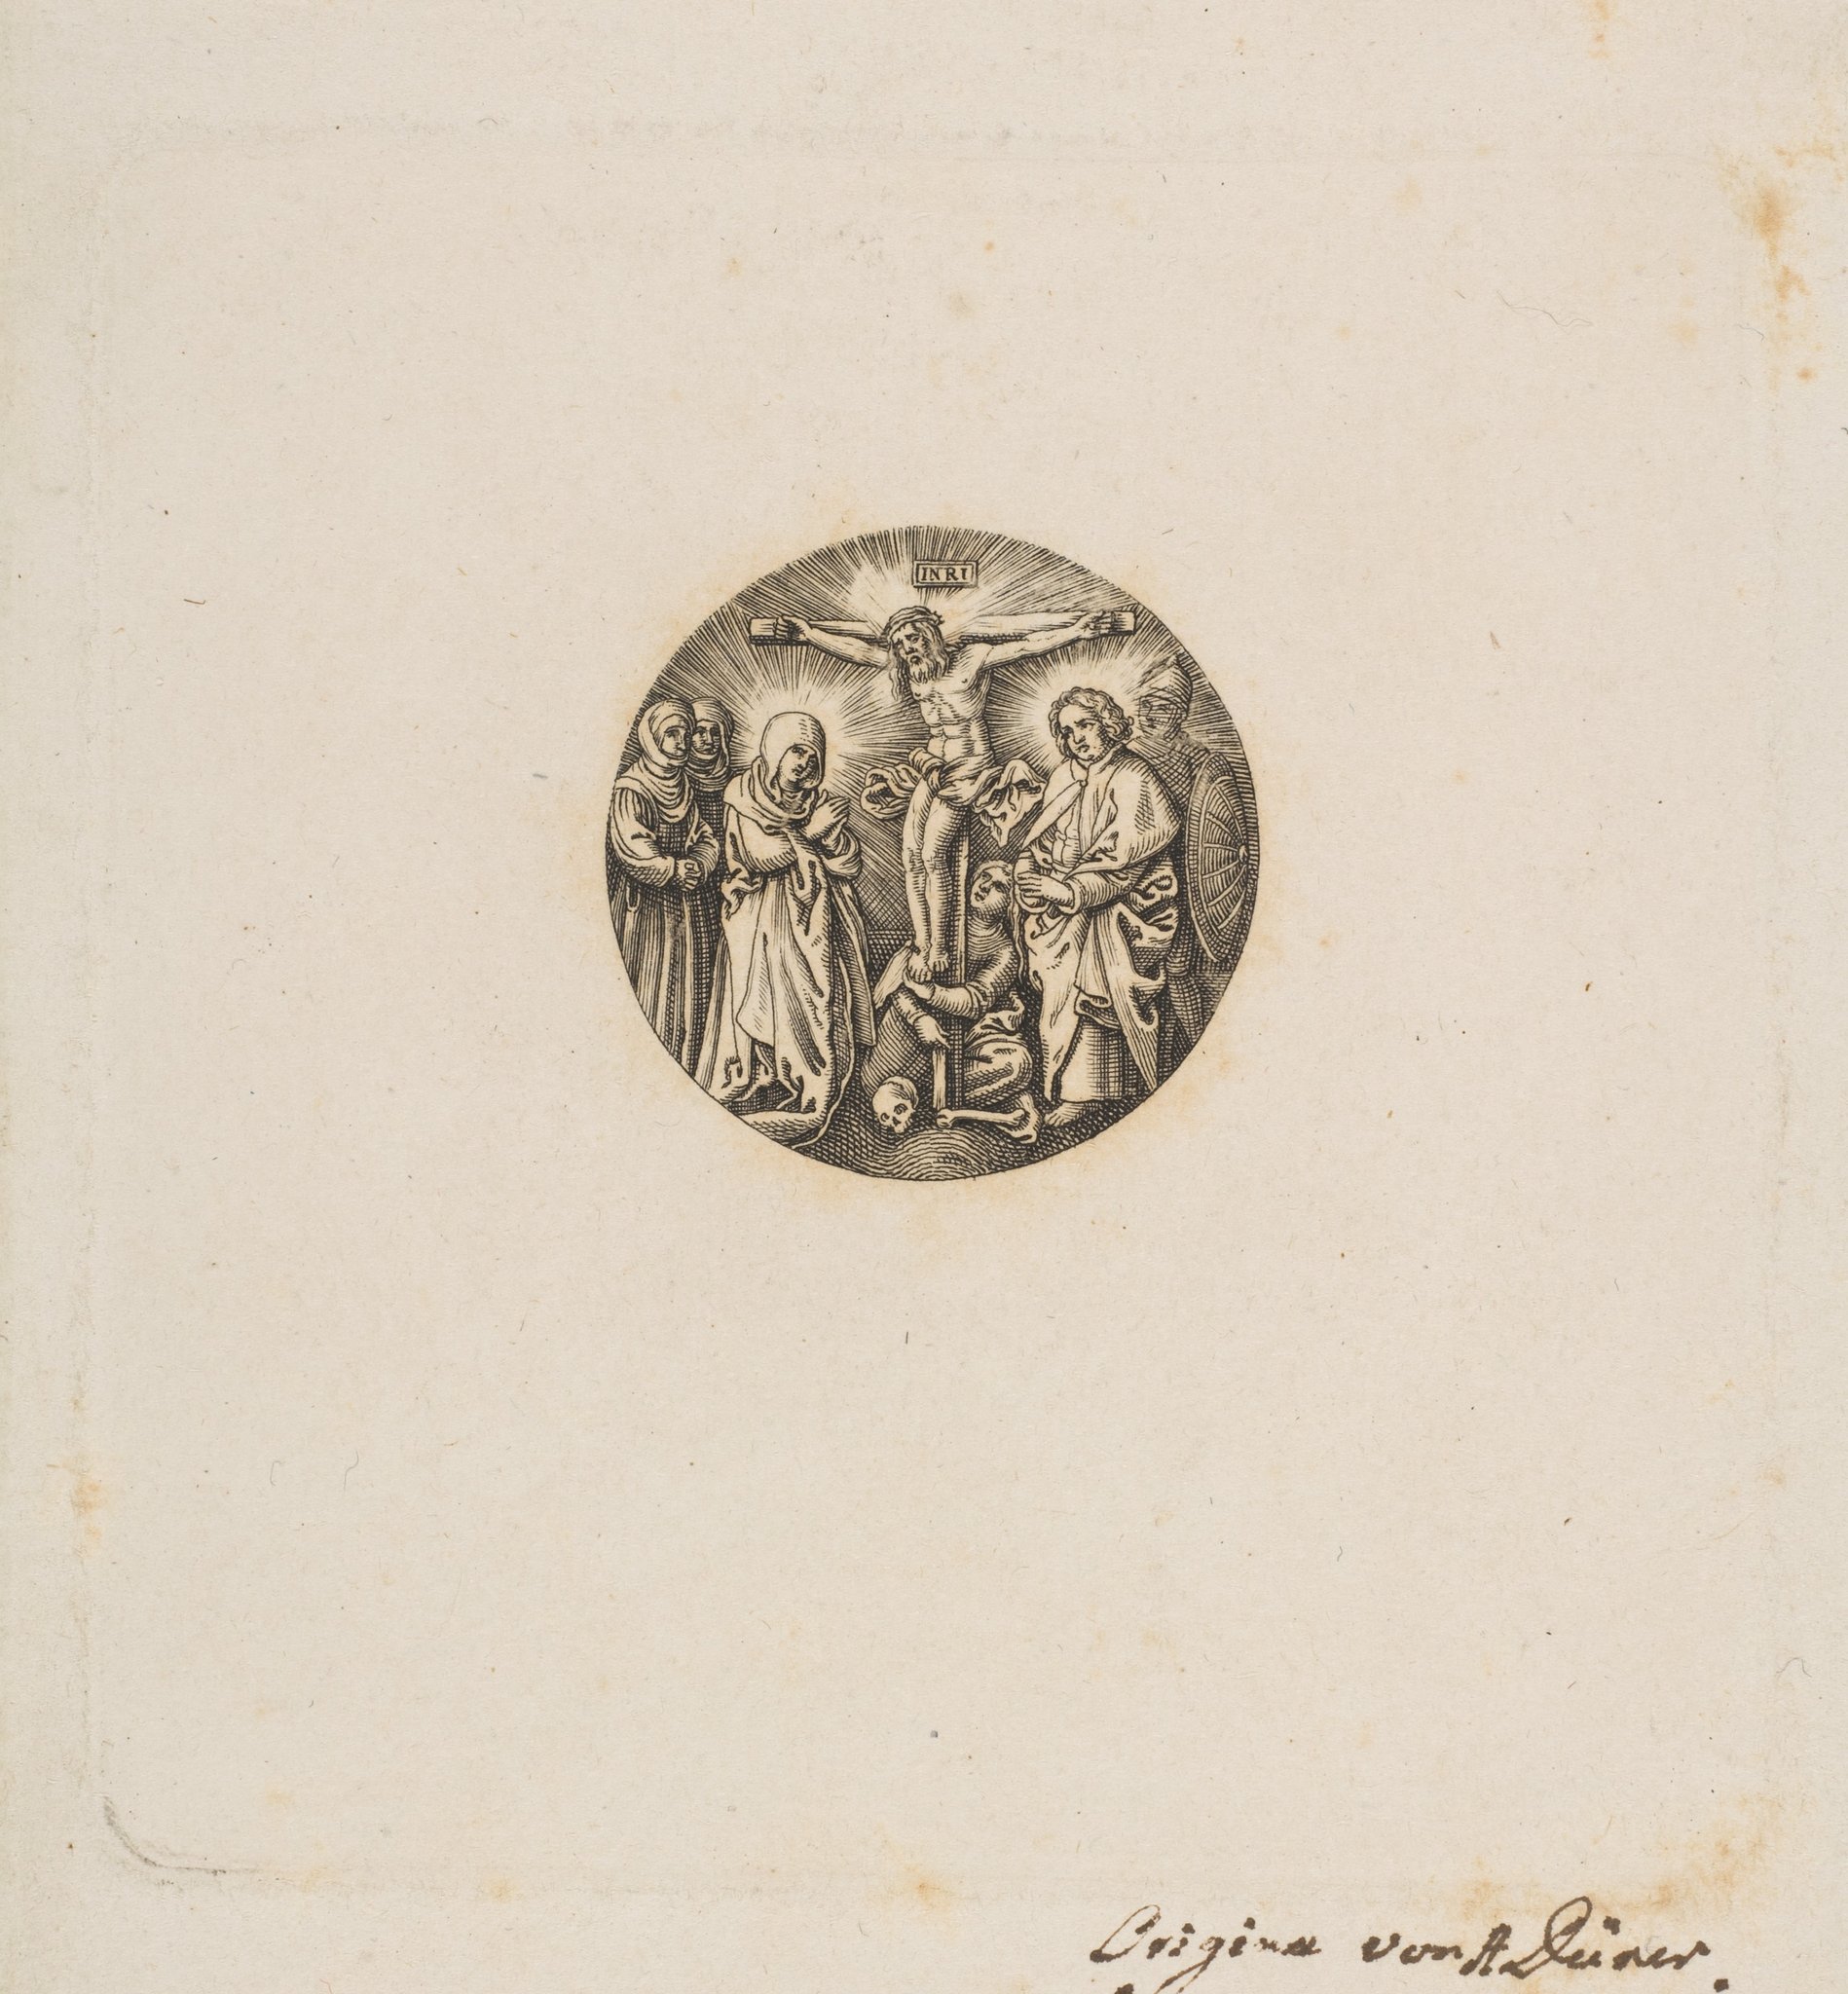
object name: print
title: The Crucifixion (Round) (copy)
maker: johannes riepenhausen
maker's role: artist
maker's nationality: german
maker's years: 1788-1860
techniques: engraving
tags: christ,crucifixion